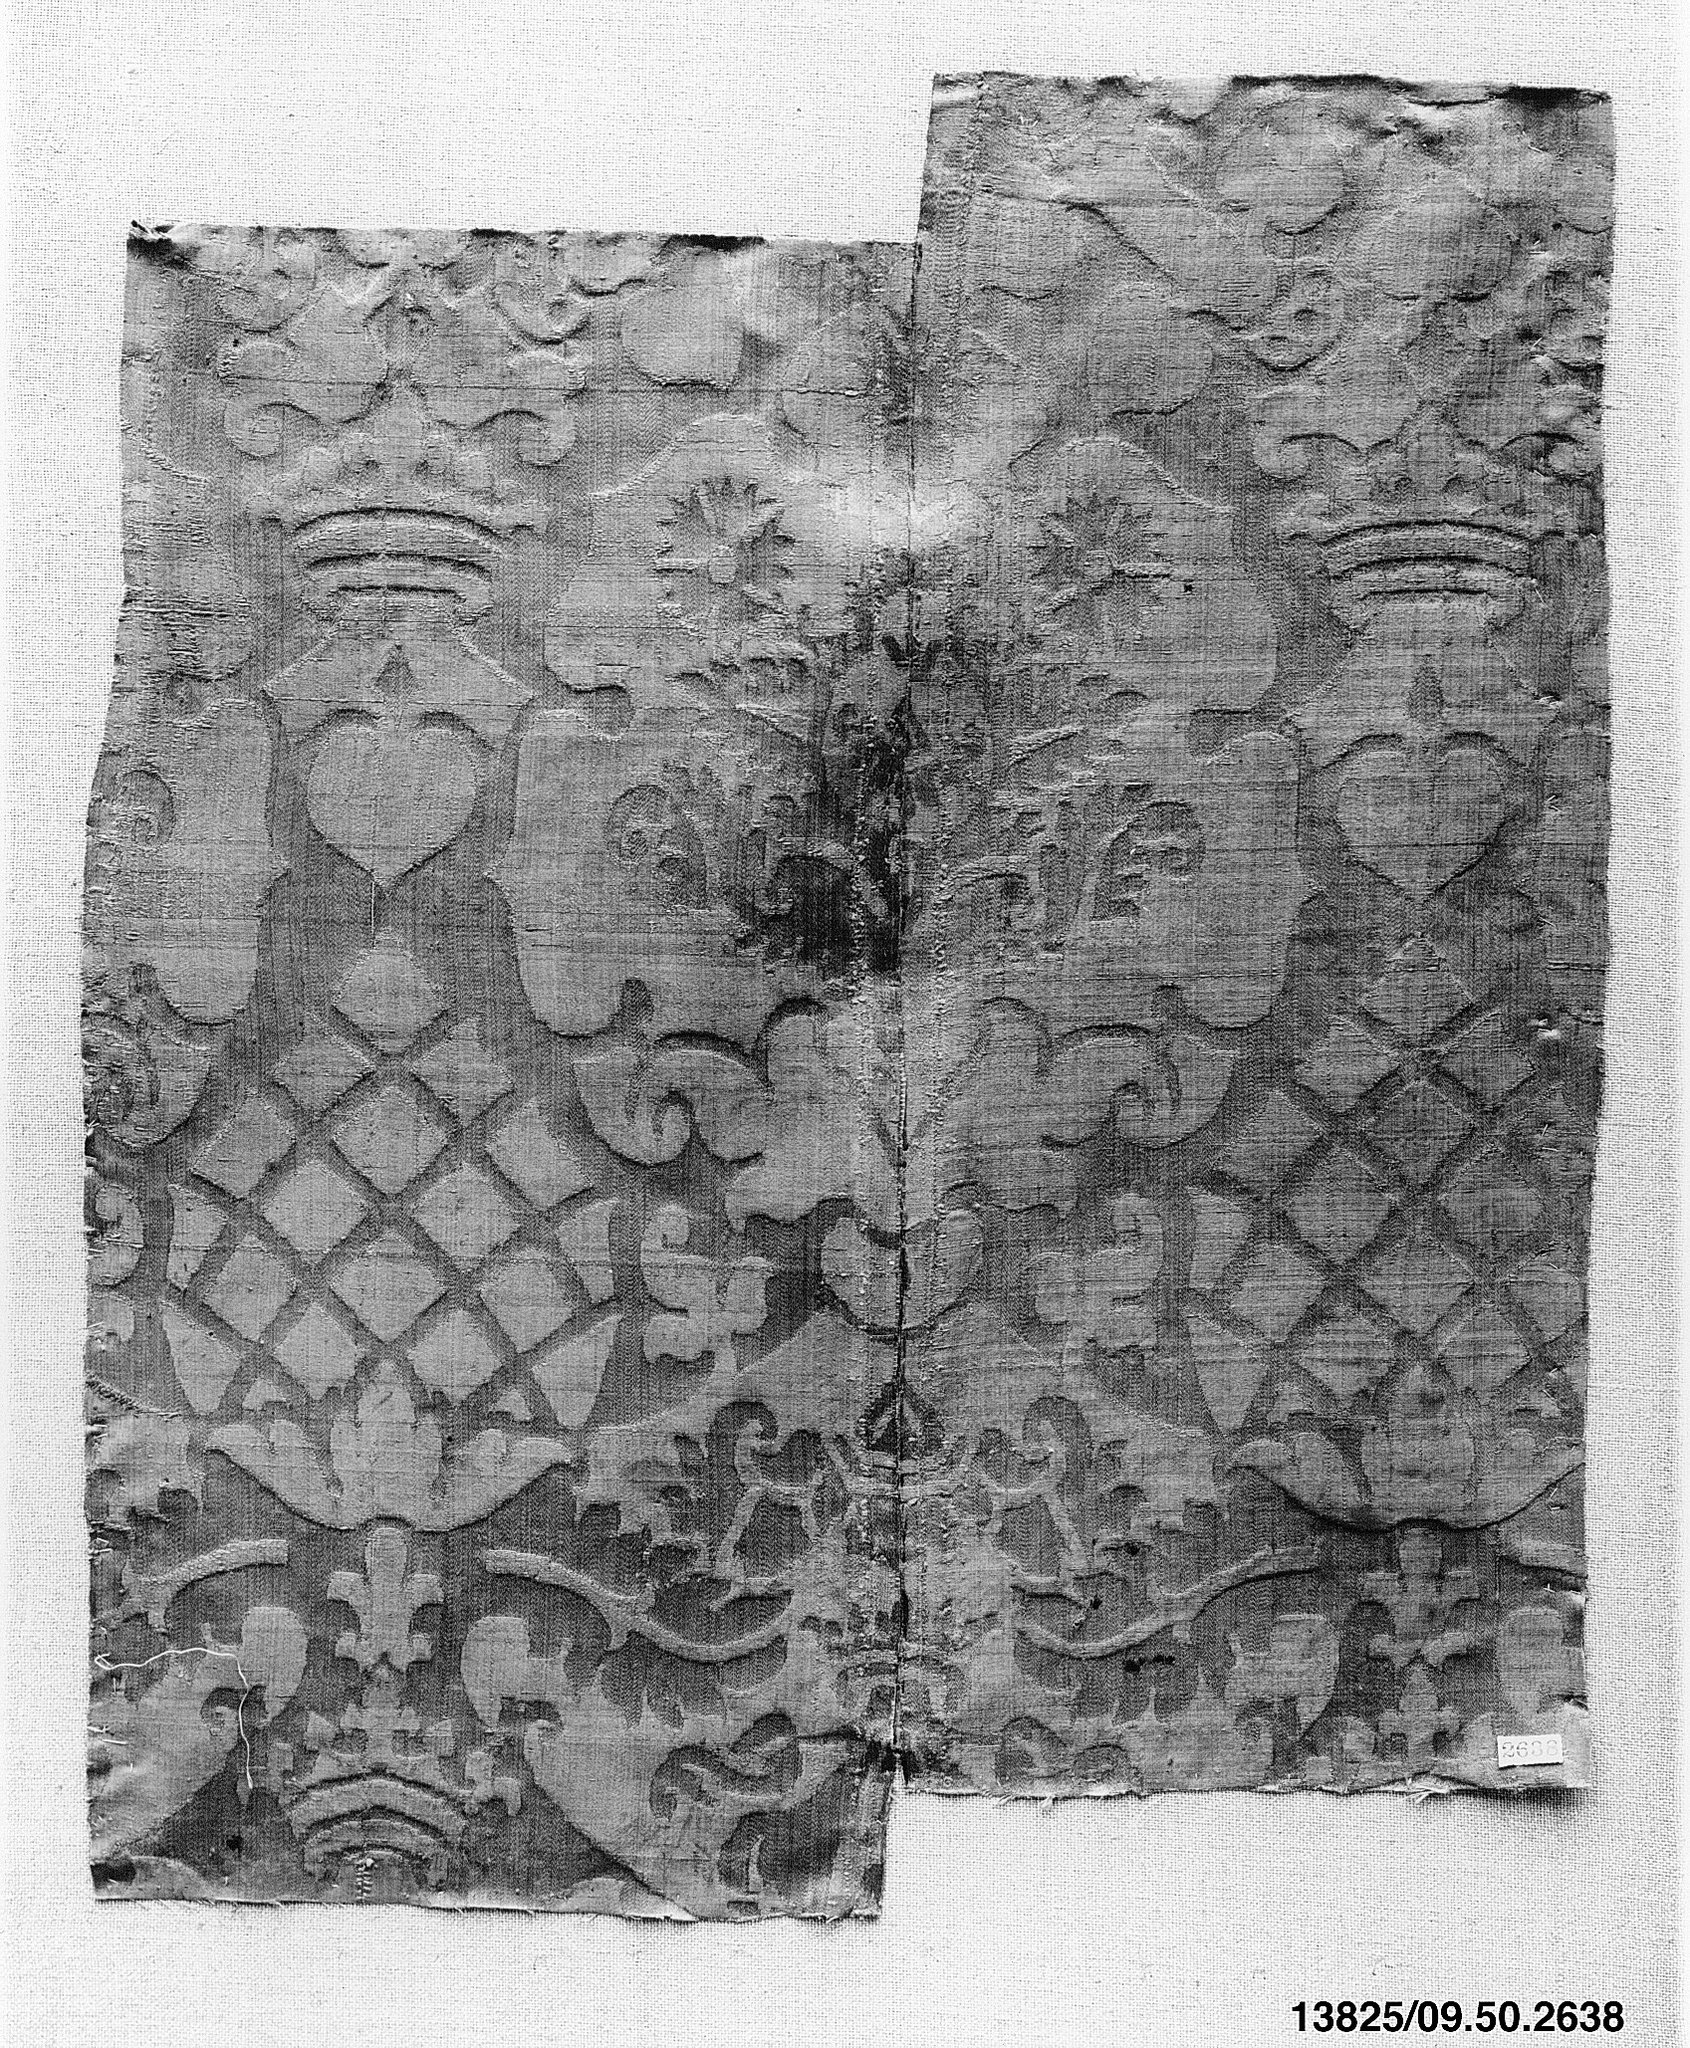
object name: piece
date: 1501-1600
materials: silk